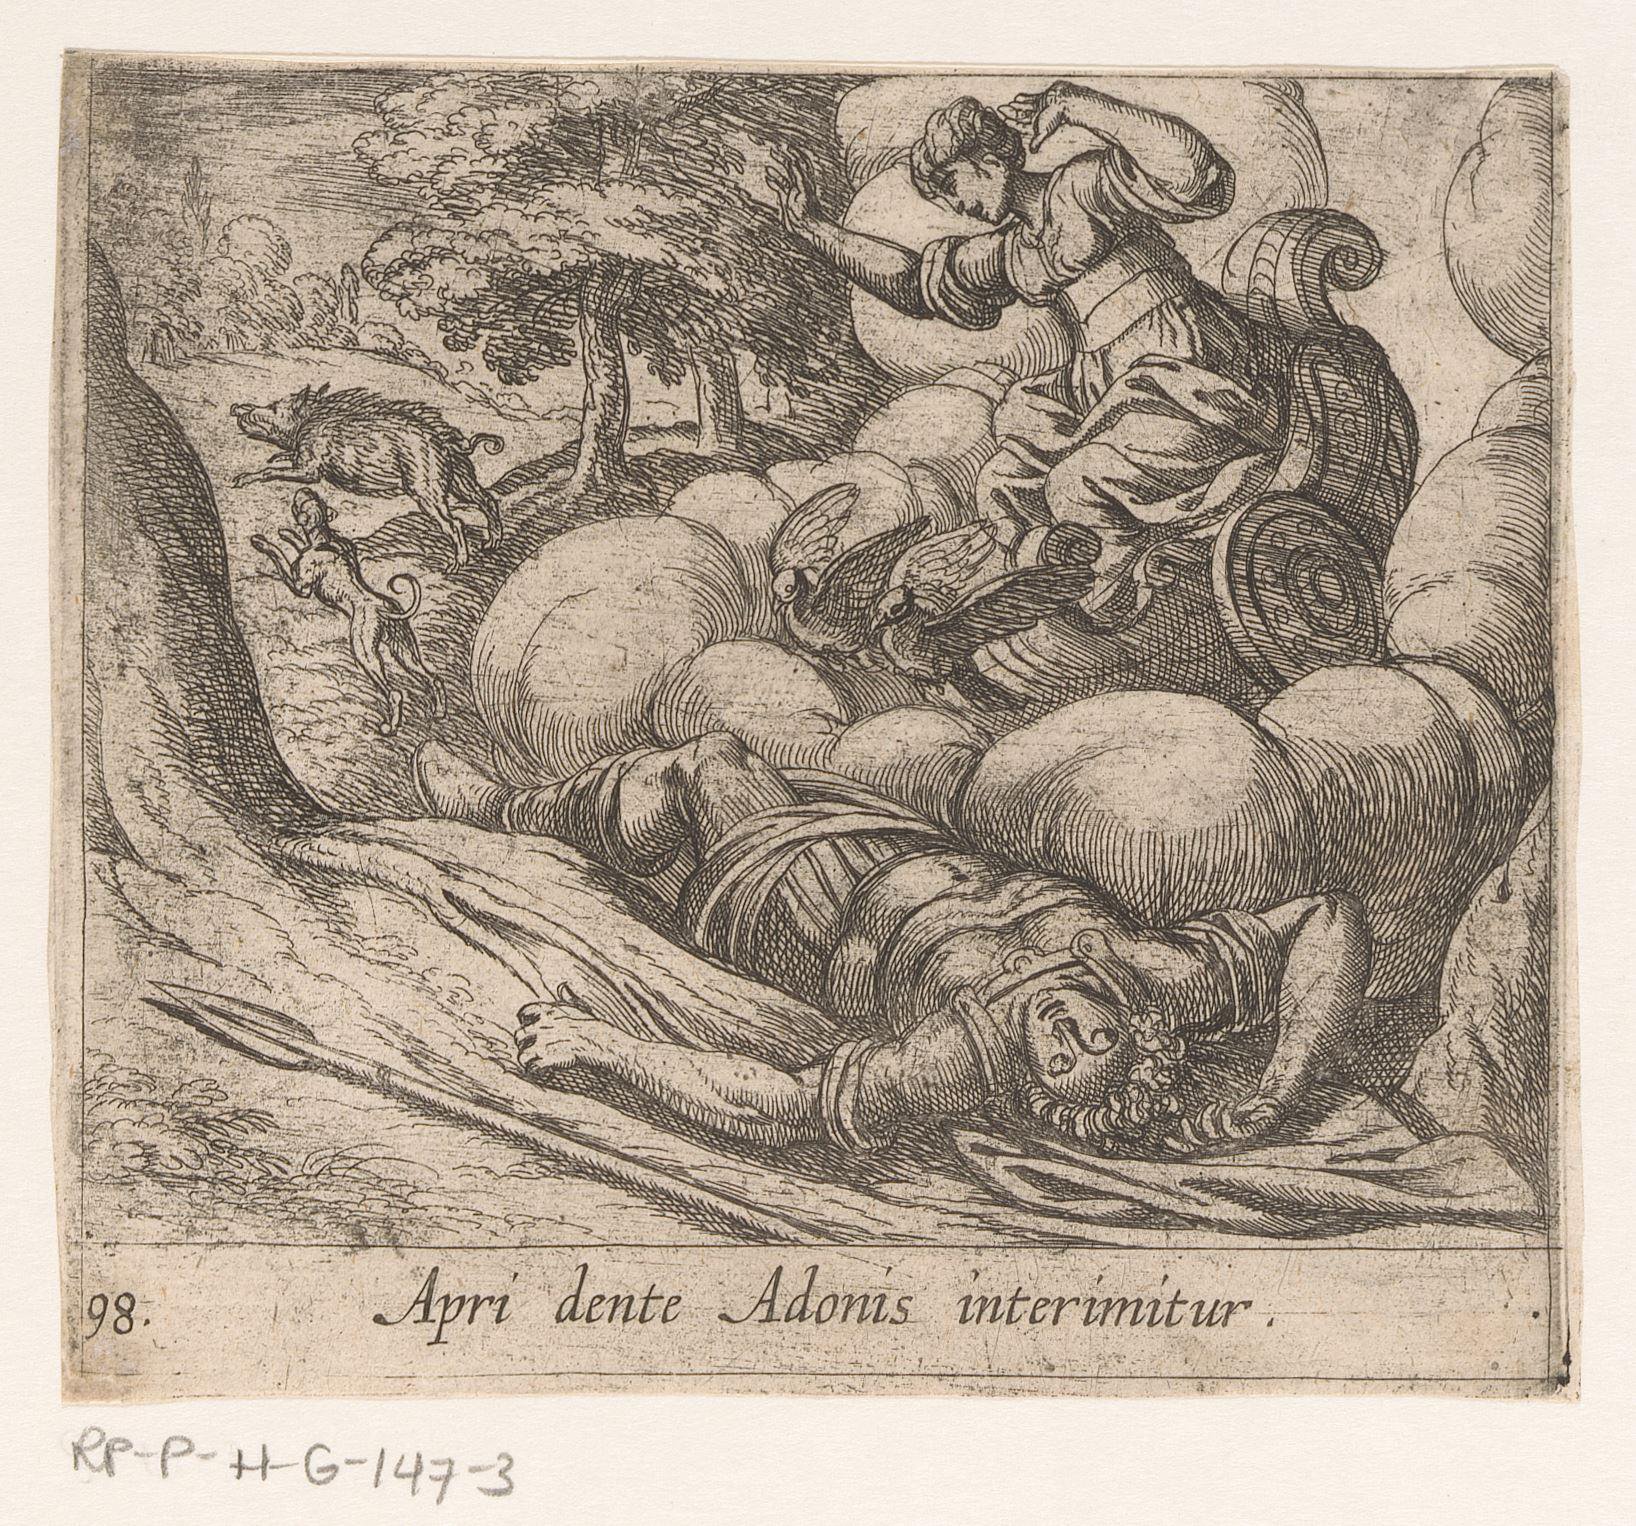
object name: print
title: Metamorphoseon sive transformationum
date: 1606-1638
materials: paper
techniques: etching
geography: amsterdam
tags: adonis' blood changed into an anemone or a rose: when adonis is slain by a boar, venus changes his blood into an anemone or a rose (ovid, metamorphoses x 735)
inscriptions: collector's mark: ‘Hinloopen’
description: Het dode lichaam van Adonis ligt op de grond. Venus, op een wagen die wordt getrokken door twee duiven, transformeert zijn bloed (in een bloem). Titel in het Latijn in ondermarge.